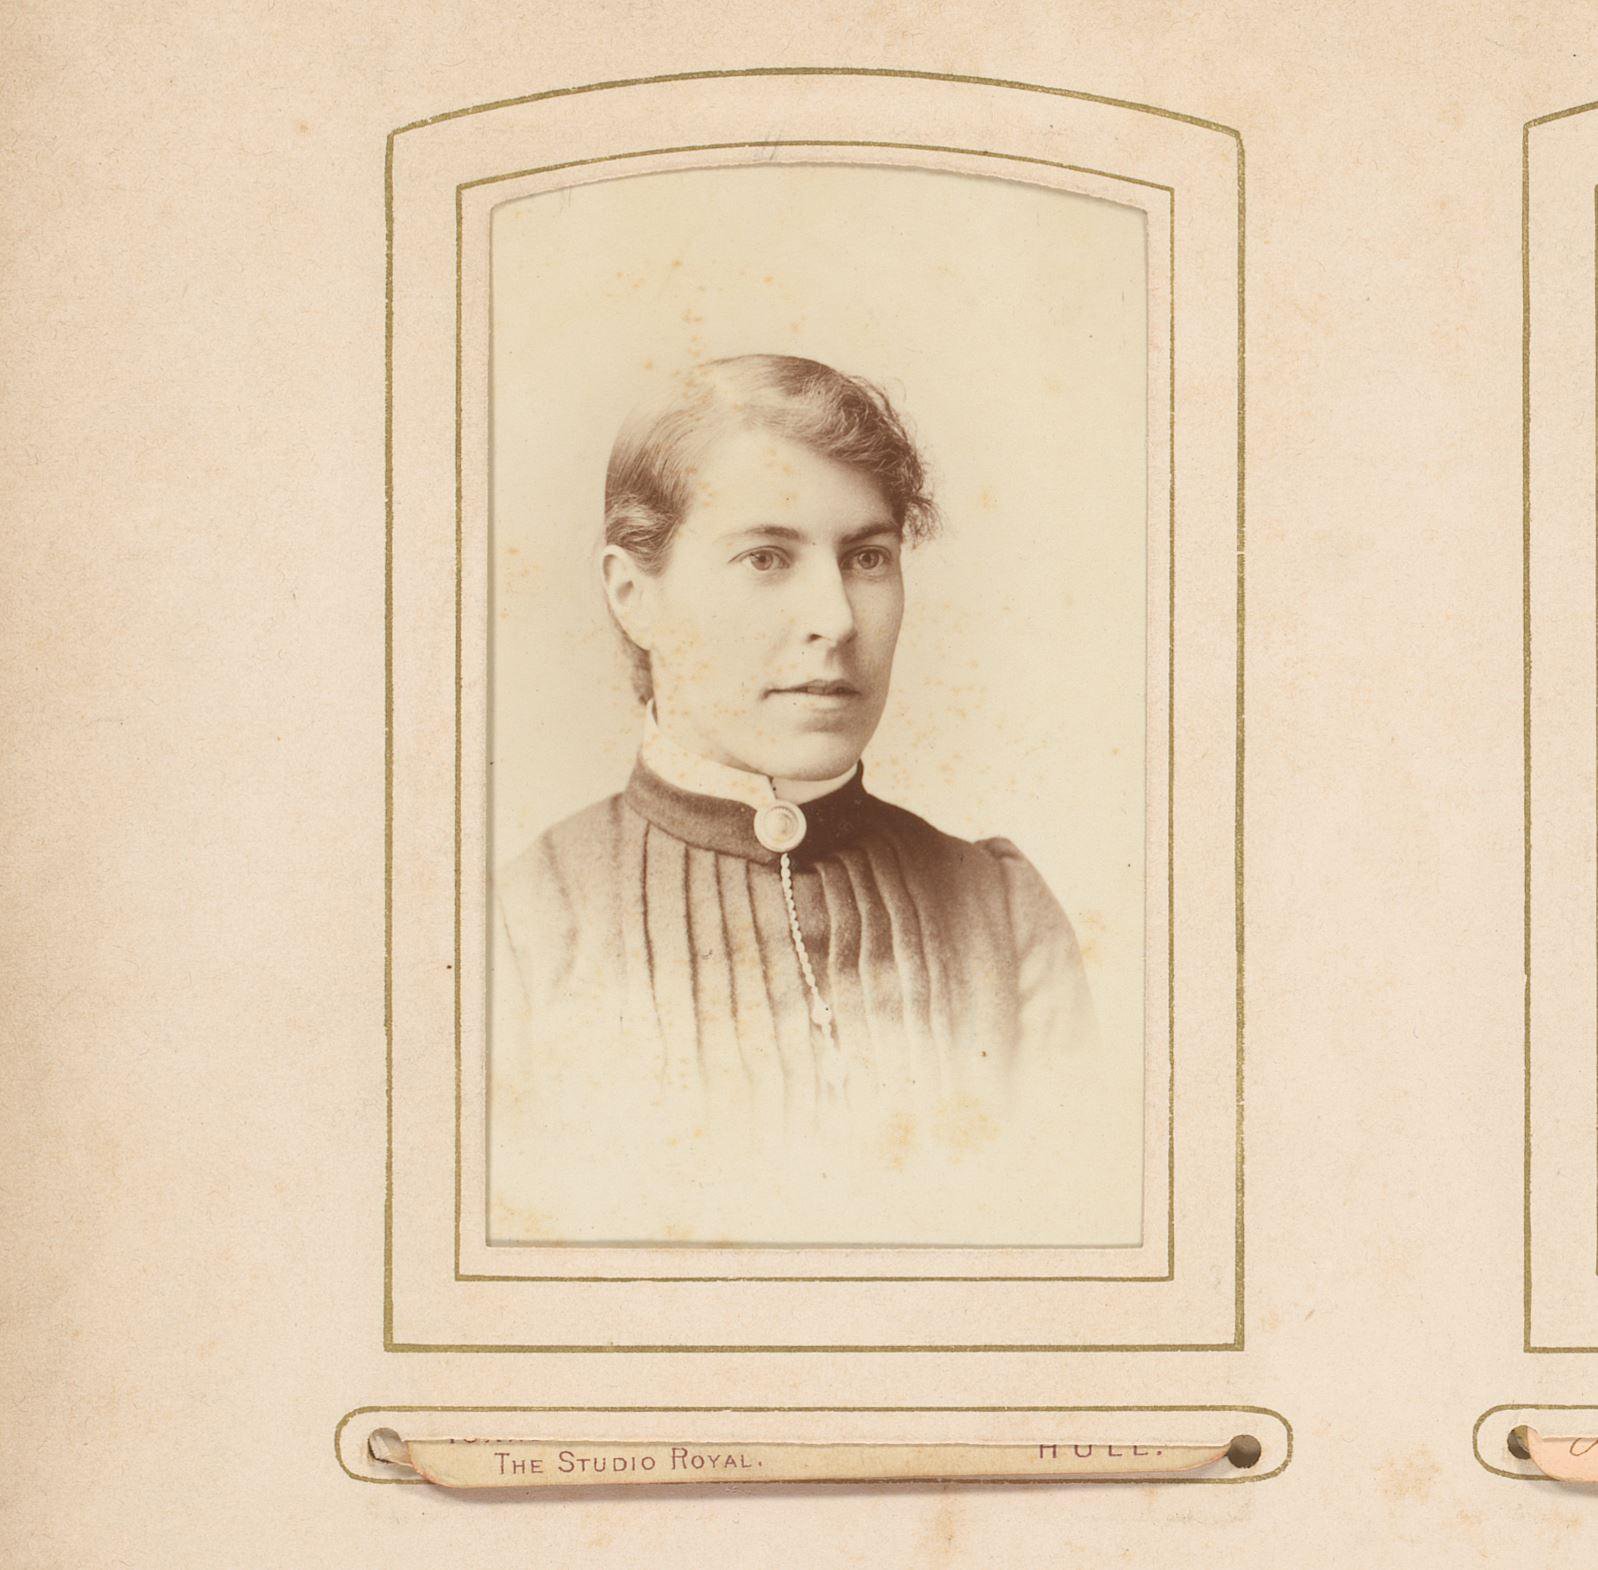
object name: carte de visite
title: Portret van een vrouw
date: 1866-1906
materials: cardboard, photographic support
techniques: albumen print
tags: adult woman, historical persons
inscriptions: inscription: ‘The Studio Royal/ Photographers to/ Turner & Drinkwater/ (...)/ Elm Tree House/ Anlaby Rad/ Hull/ (...)’